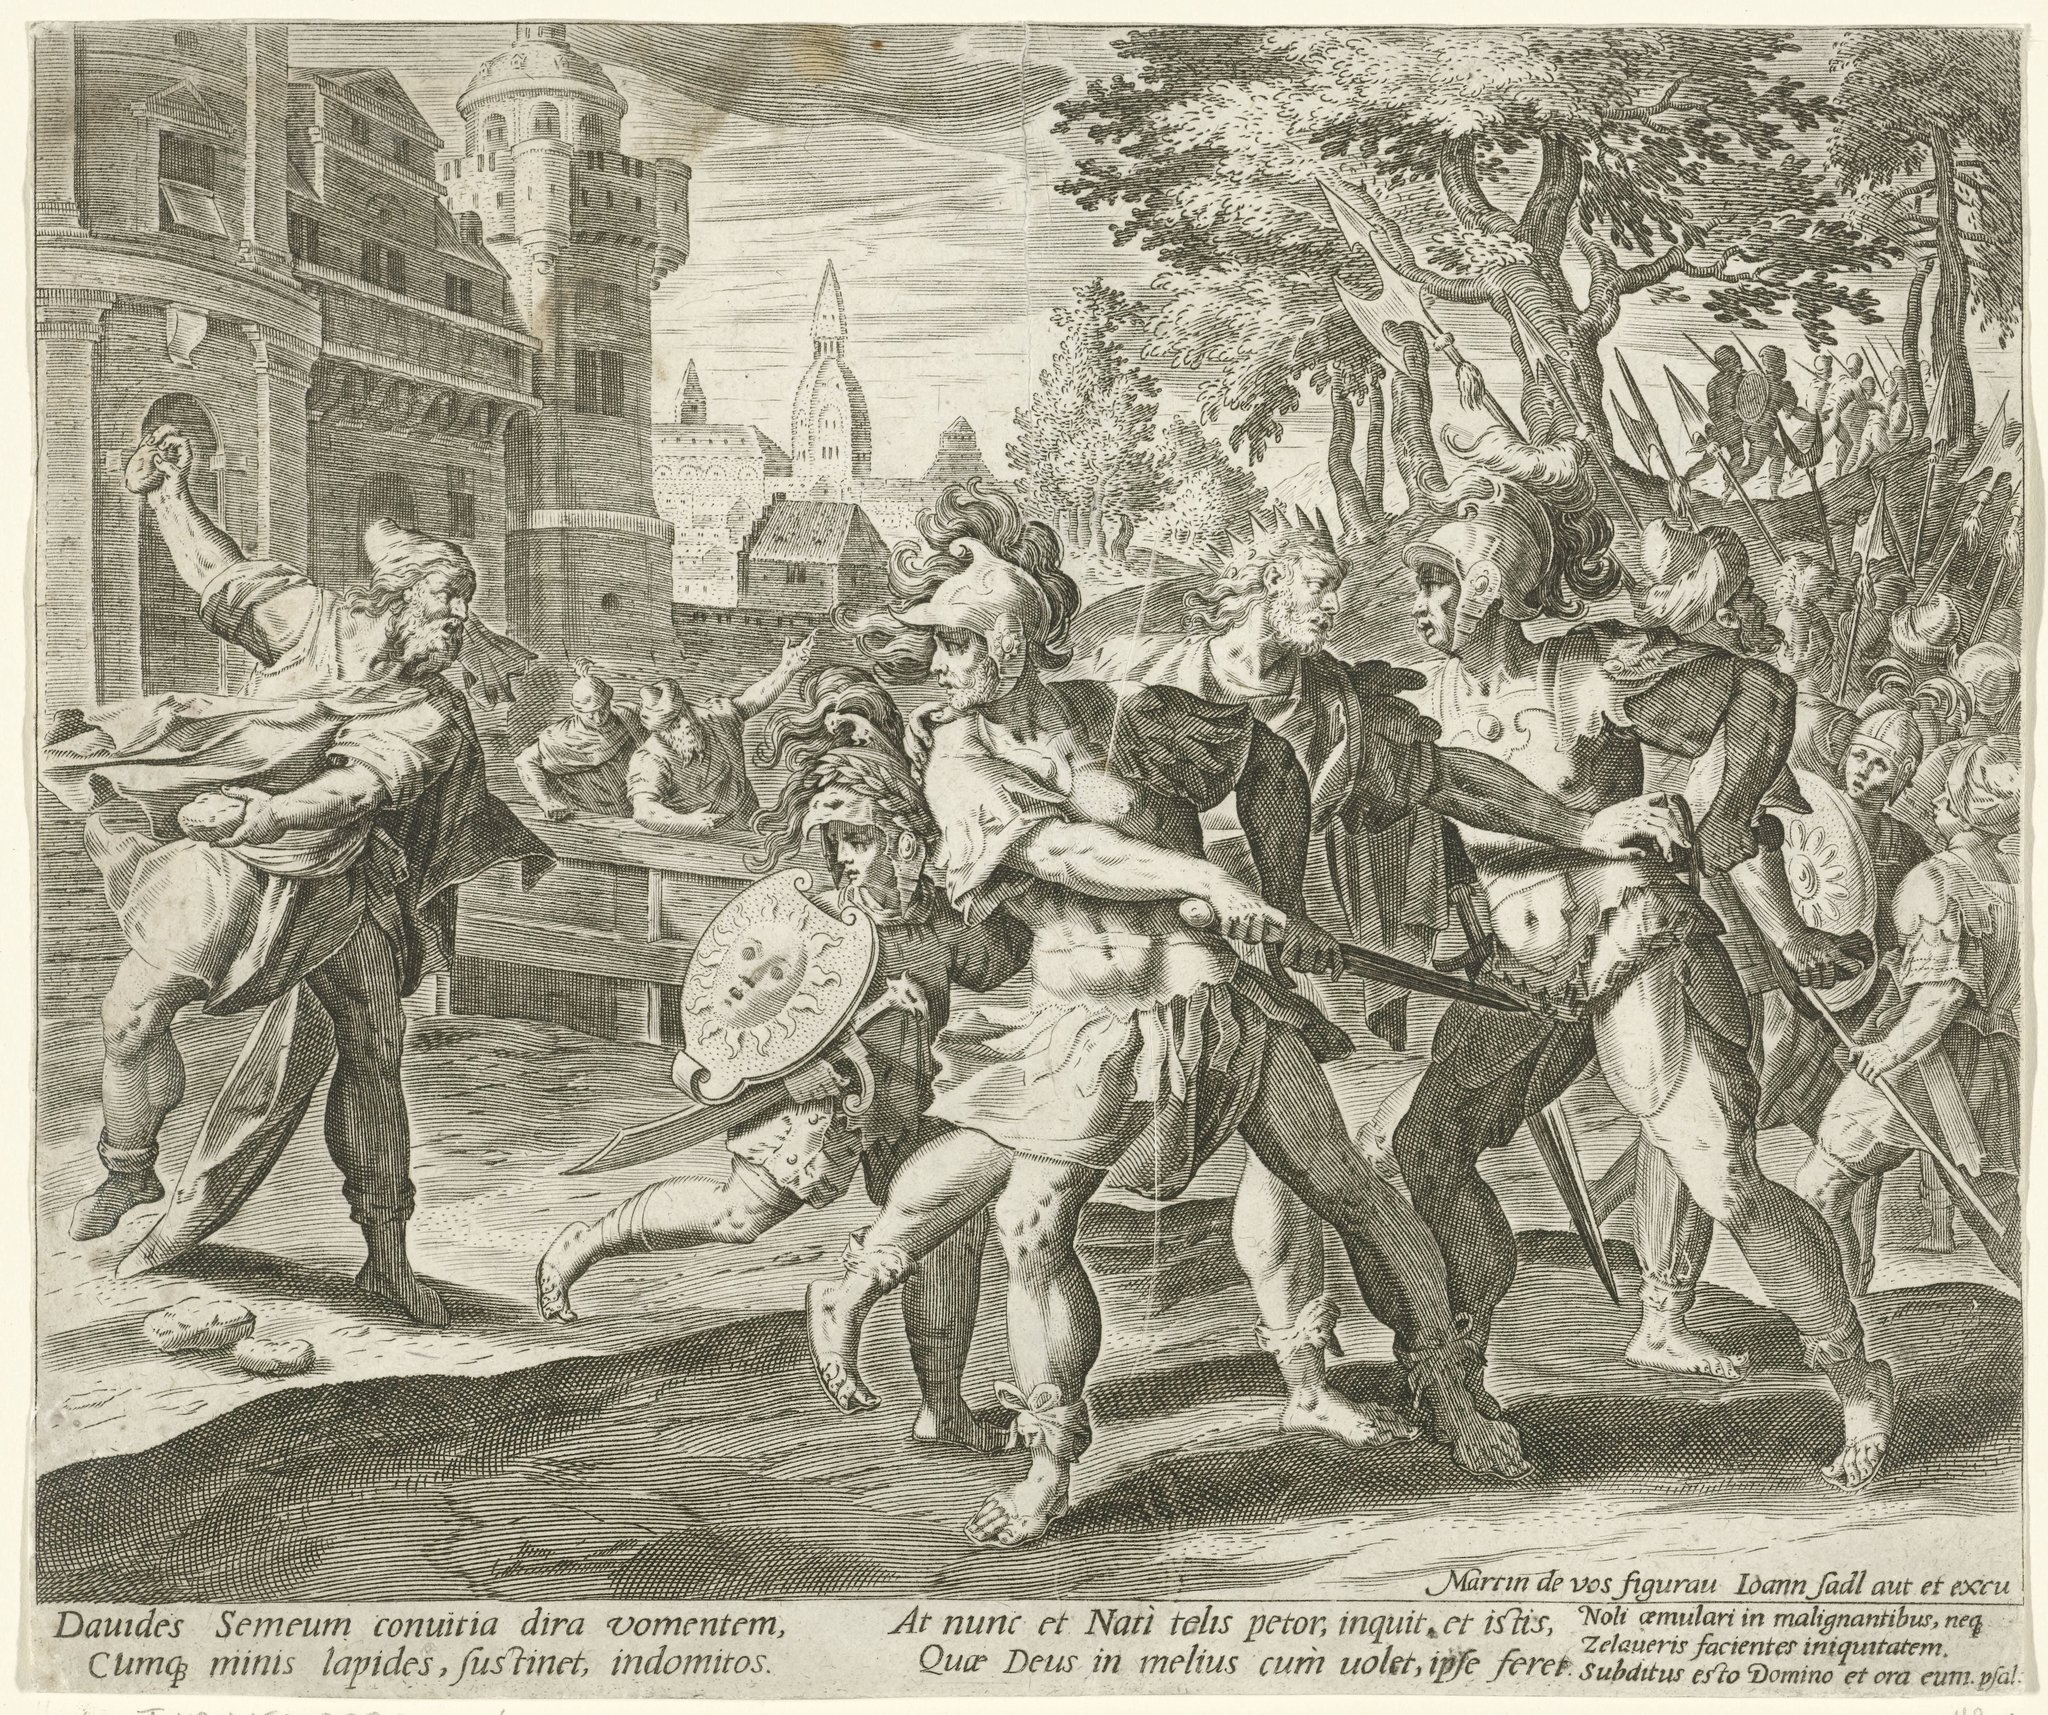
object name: print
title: Geschiedenis van David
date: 1580-1596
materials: paper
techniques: engraving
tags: shimei curses david and casts stones at him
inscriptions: collector's mark: Lugt 2760, collector's mark: Lugt 2228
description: Simi vervloekt koning David en gooit stenen naar hem. De soldaten van David willen hem verdedigen maar de koning houdt hen tegen. De prent heeft een Latijns onderschrift met uitleg en rechts in de hoek een vers uit psalm 36.